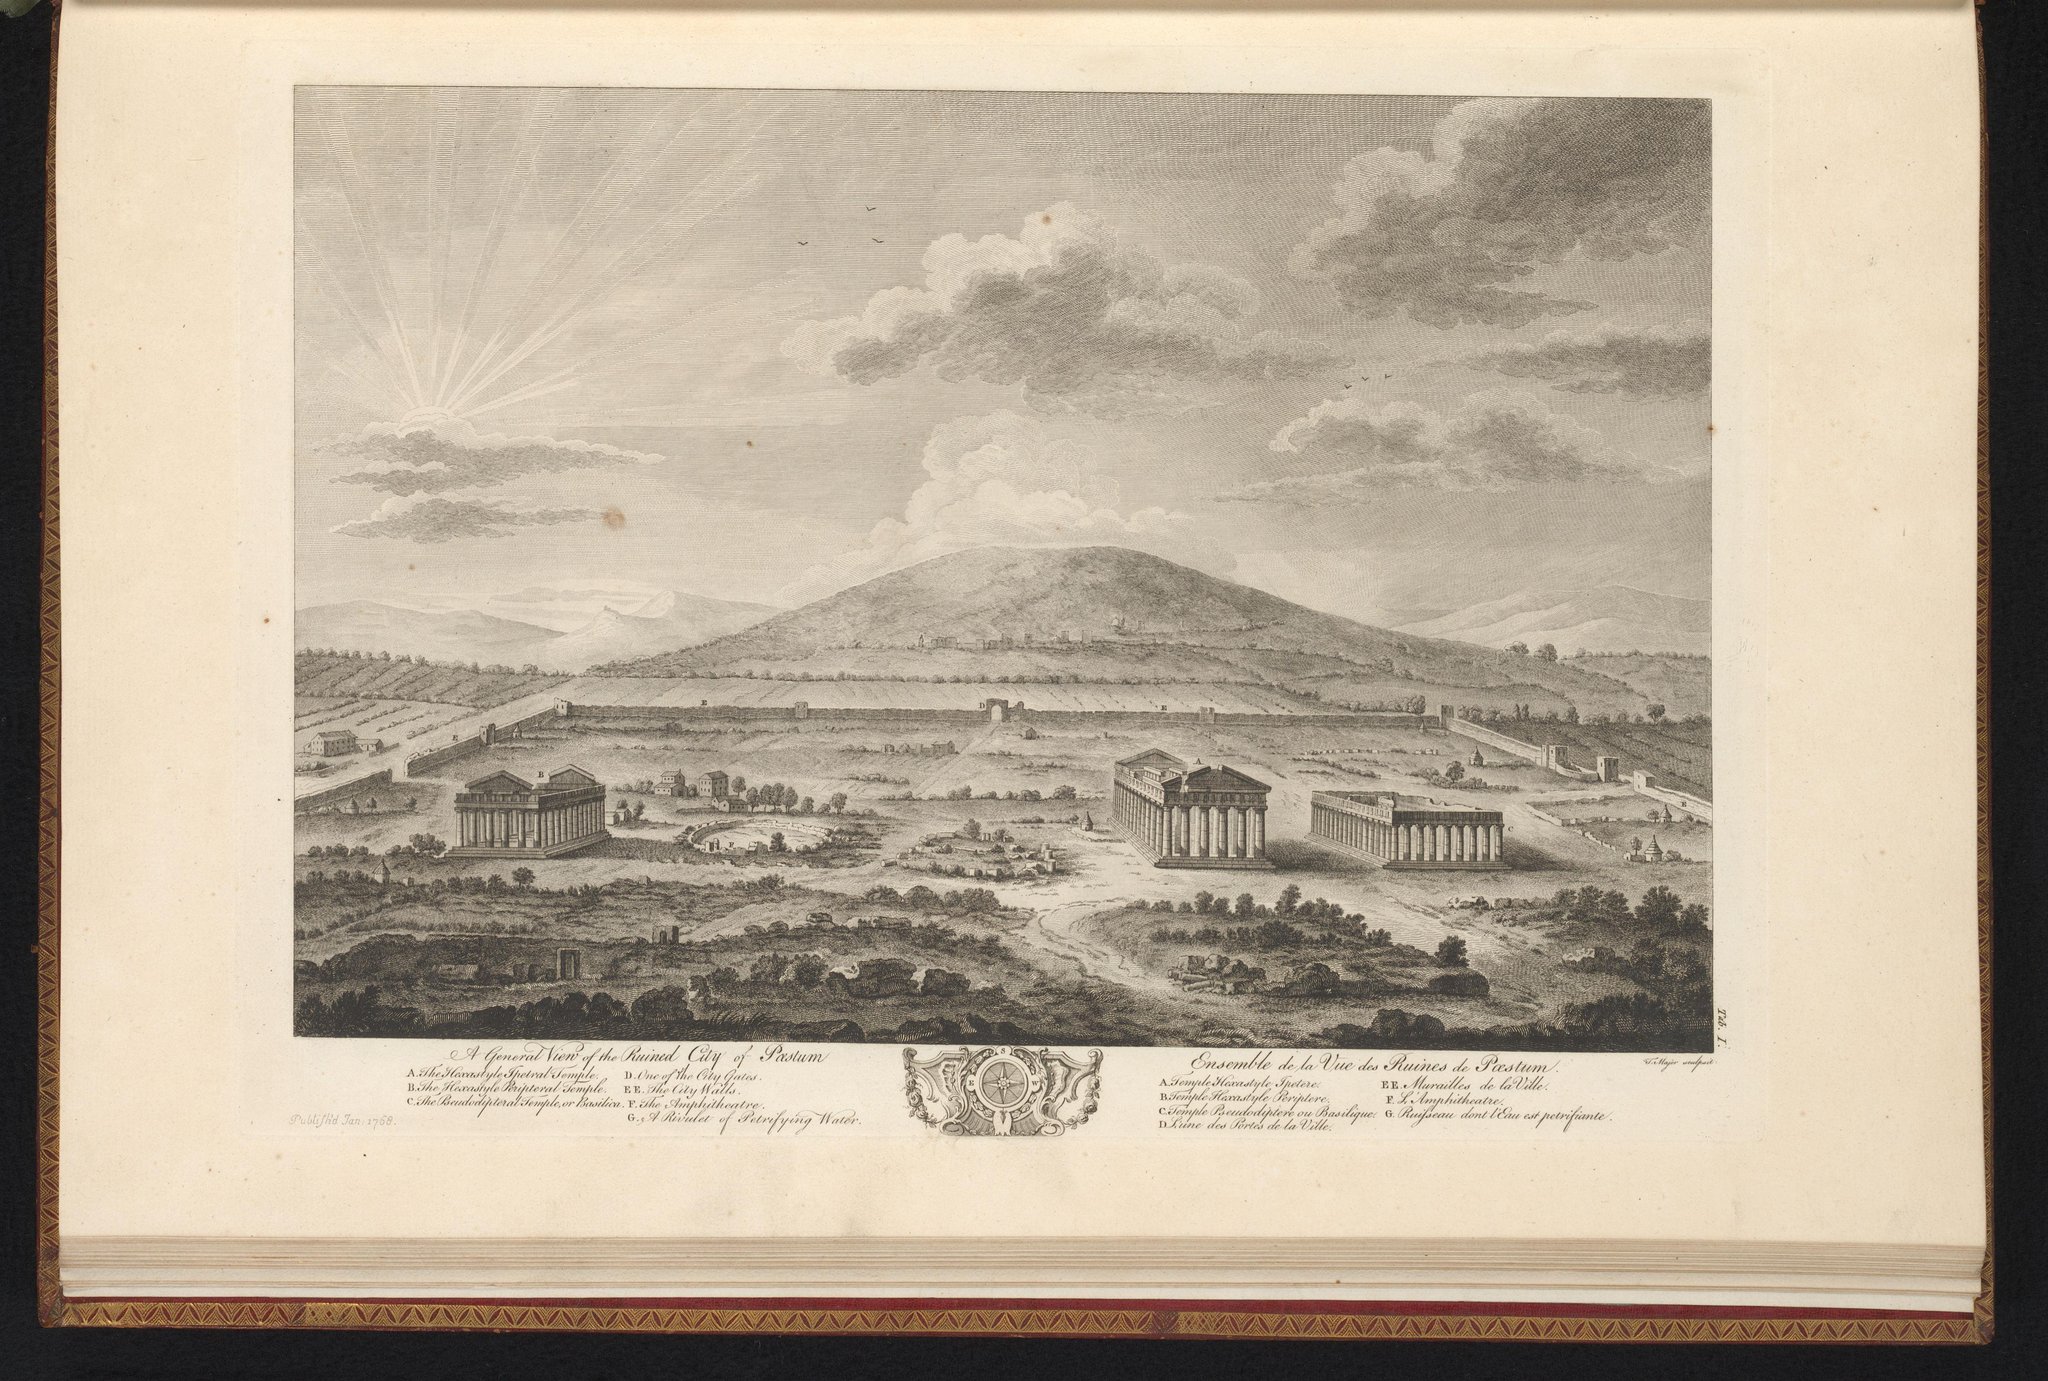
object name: print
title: Gezicht op de ruïnes van Paestum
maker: thomas major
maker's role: print maker, publisher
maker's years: 1714-1799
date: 1768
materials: paper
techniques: engraving, etching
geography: london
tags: landscape with ruins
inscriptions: date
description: Deze prent is onderdeel van de reeks van 25 genummerde illustraties in deze uitgave.